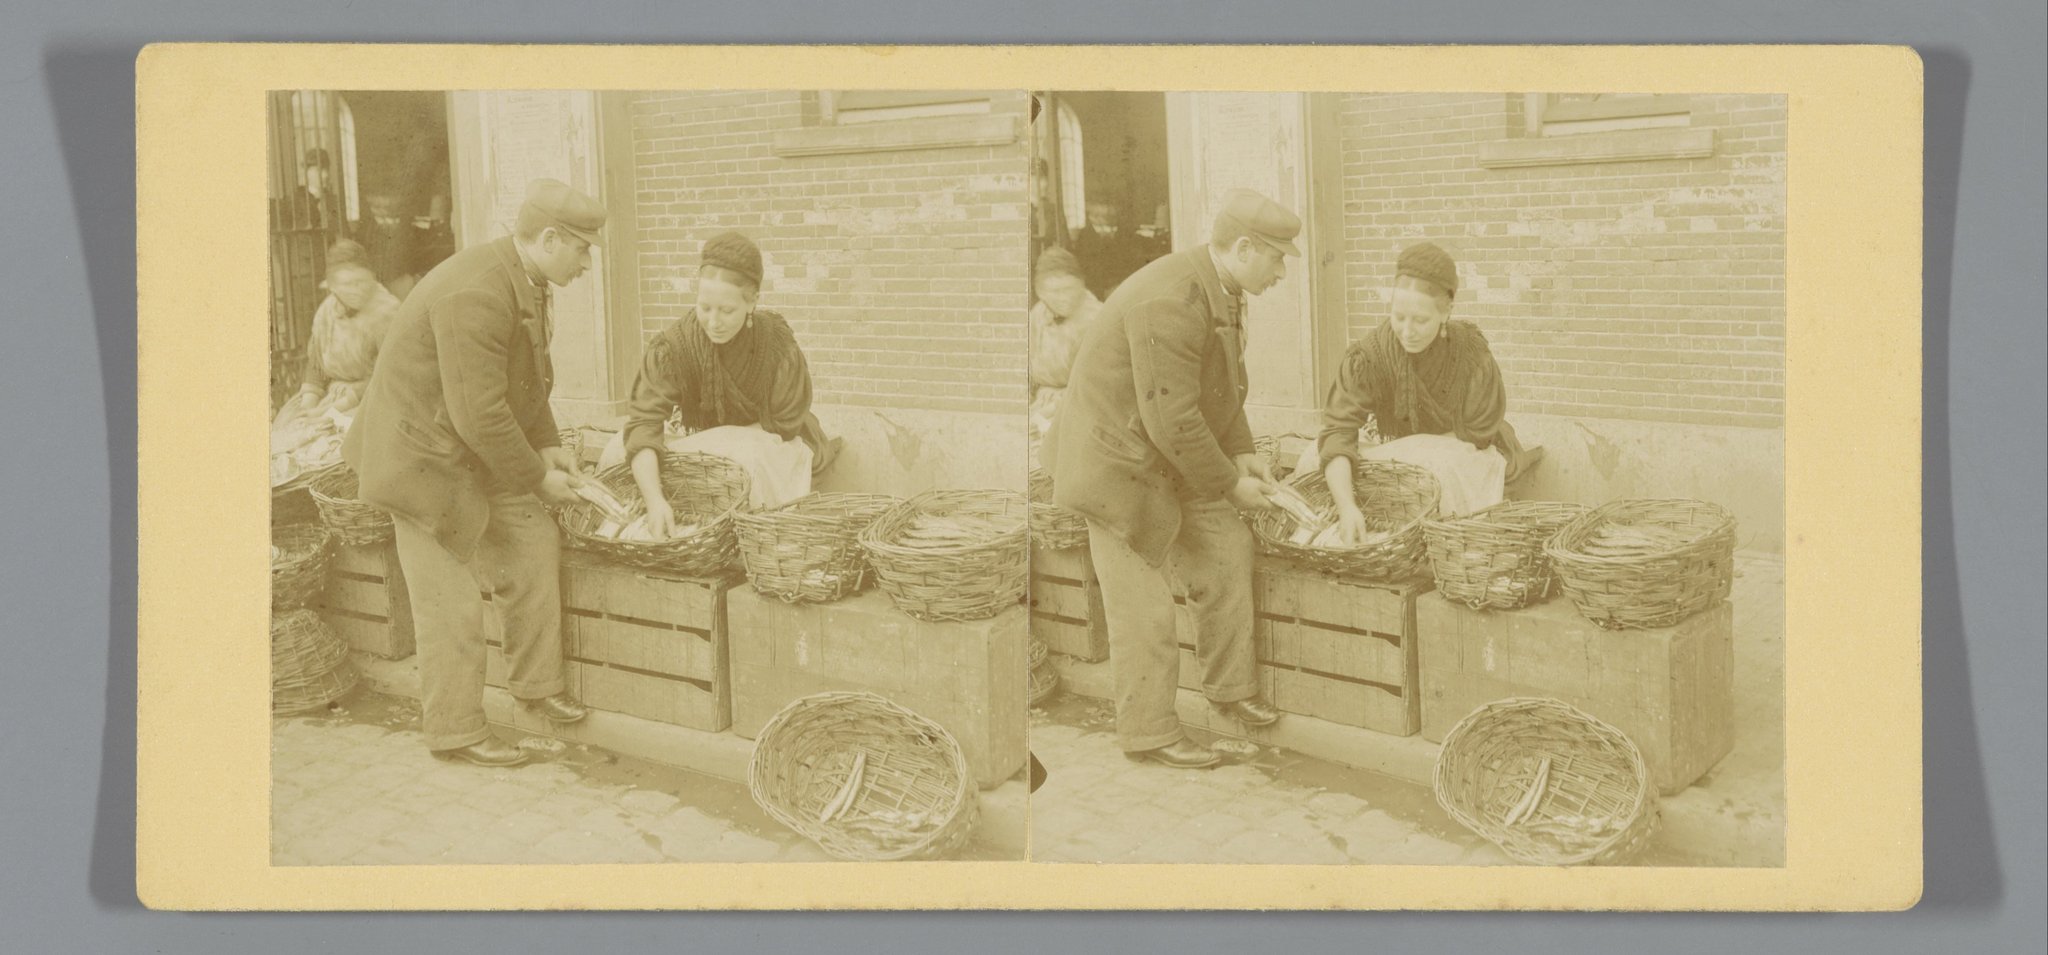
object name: stereograph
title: Visverkoopster bedient een klant, Nederland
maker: Anonymous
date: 1897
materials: paper, cardboard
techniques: gelatin silver print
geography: netherlands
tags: fishes, stall, booth (~ market), netherlands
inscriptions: inscription: ‘Tentoonstelling 1897/ op Museumplein? A'dam’